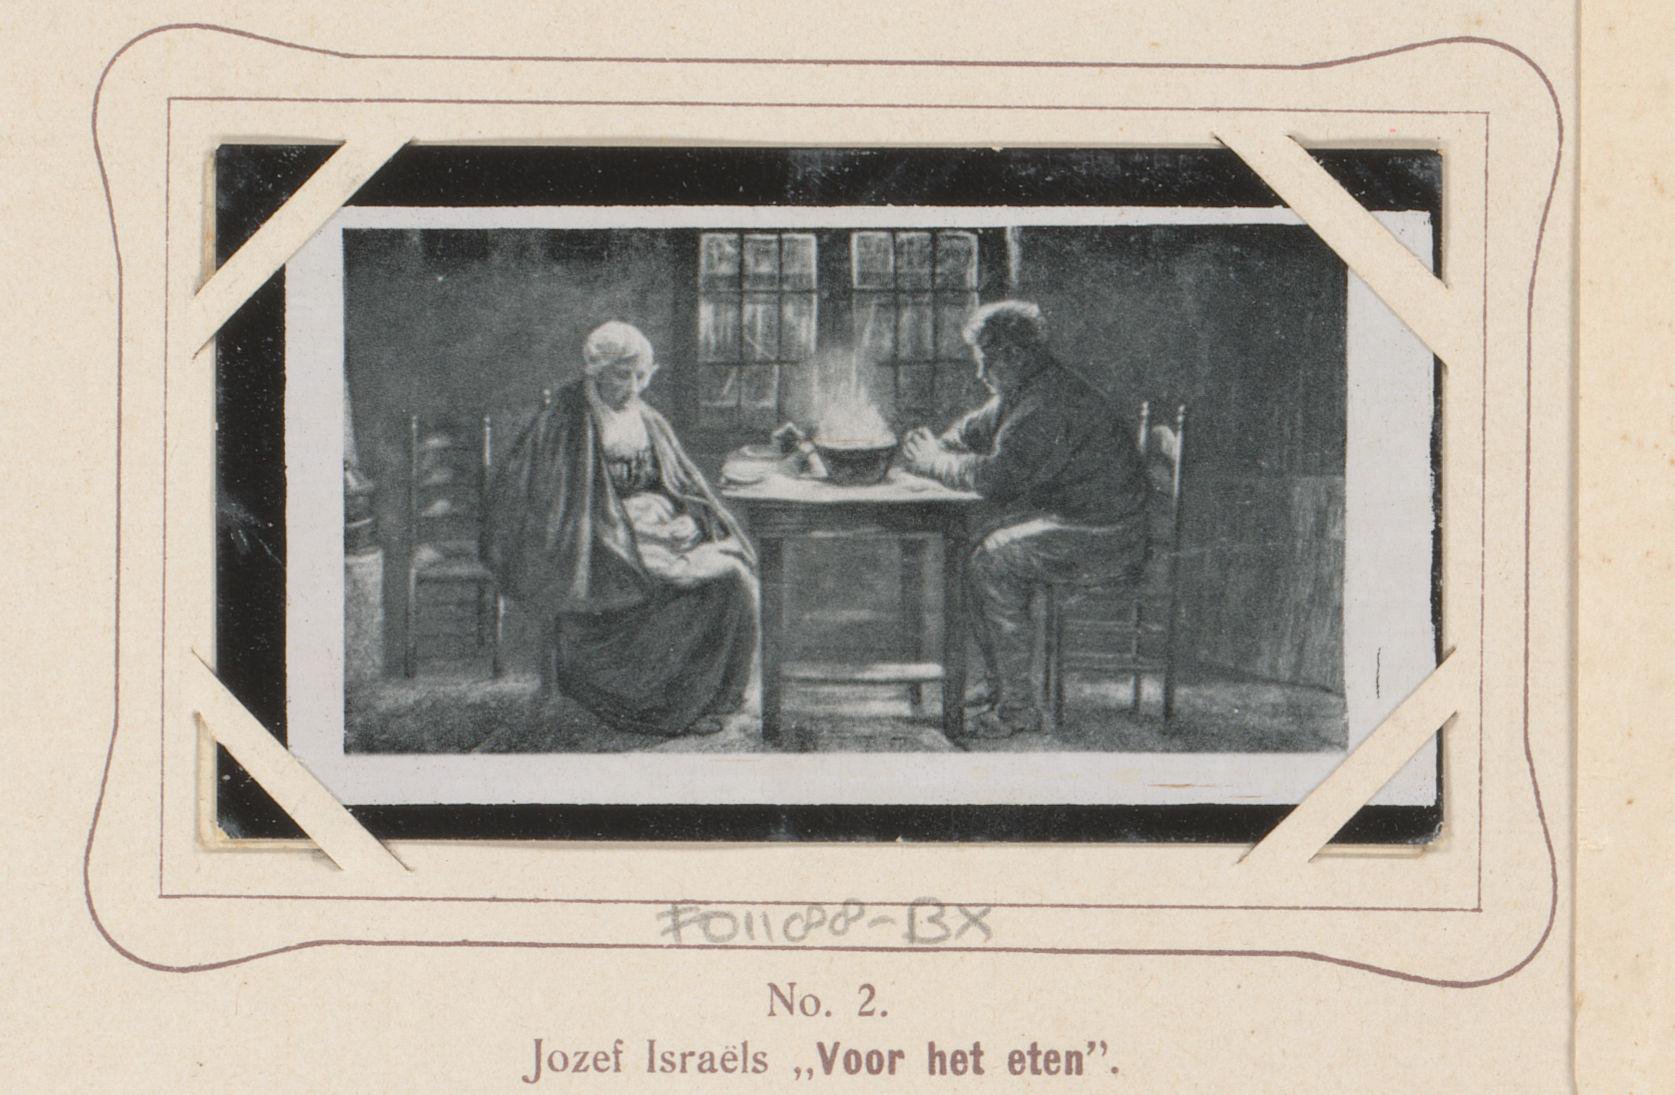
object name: reproduction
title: Reproductie van een schilderij van een man en vrouw aan tafel naar Jozef Israëls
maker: Anonymous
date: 1906-1907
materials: paper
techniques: photograph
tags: family life at home, evening meal, dinner, supper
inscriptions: inscription: ‘No. 2./ Jozef Israëls "voor het eten".’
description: Deze prent maakt deel uit van een album.